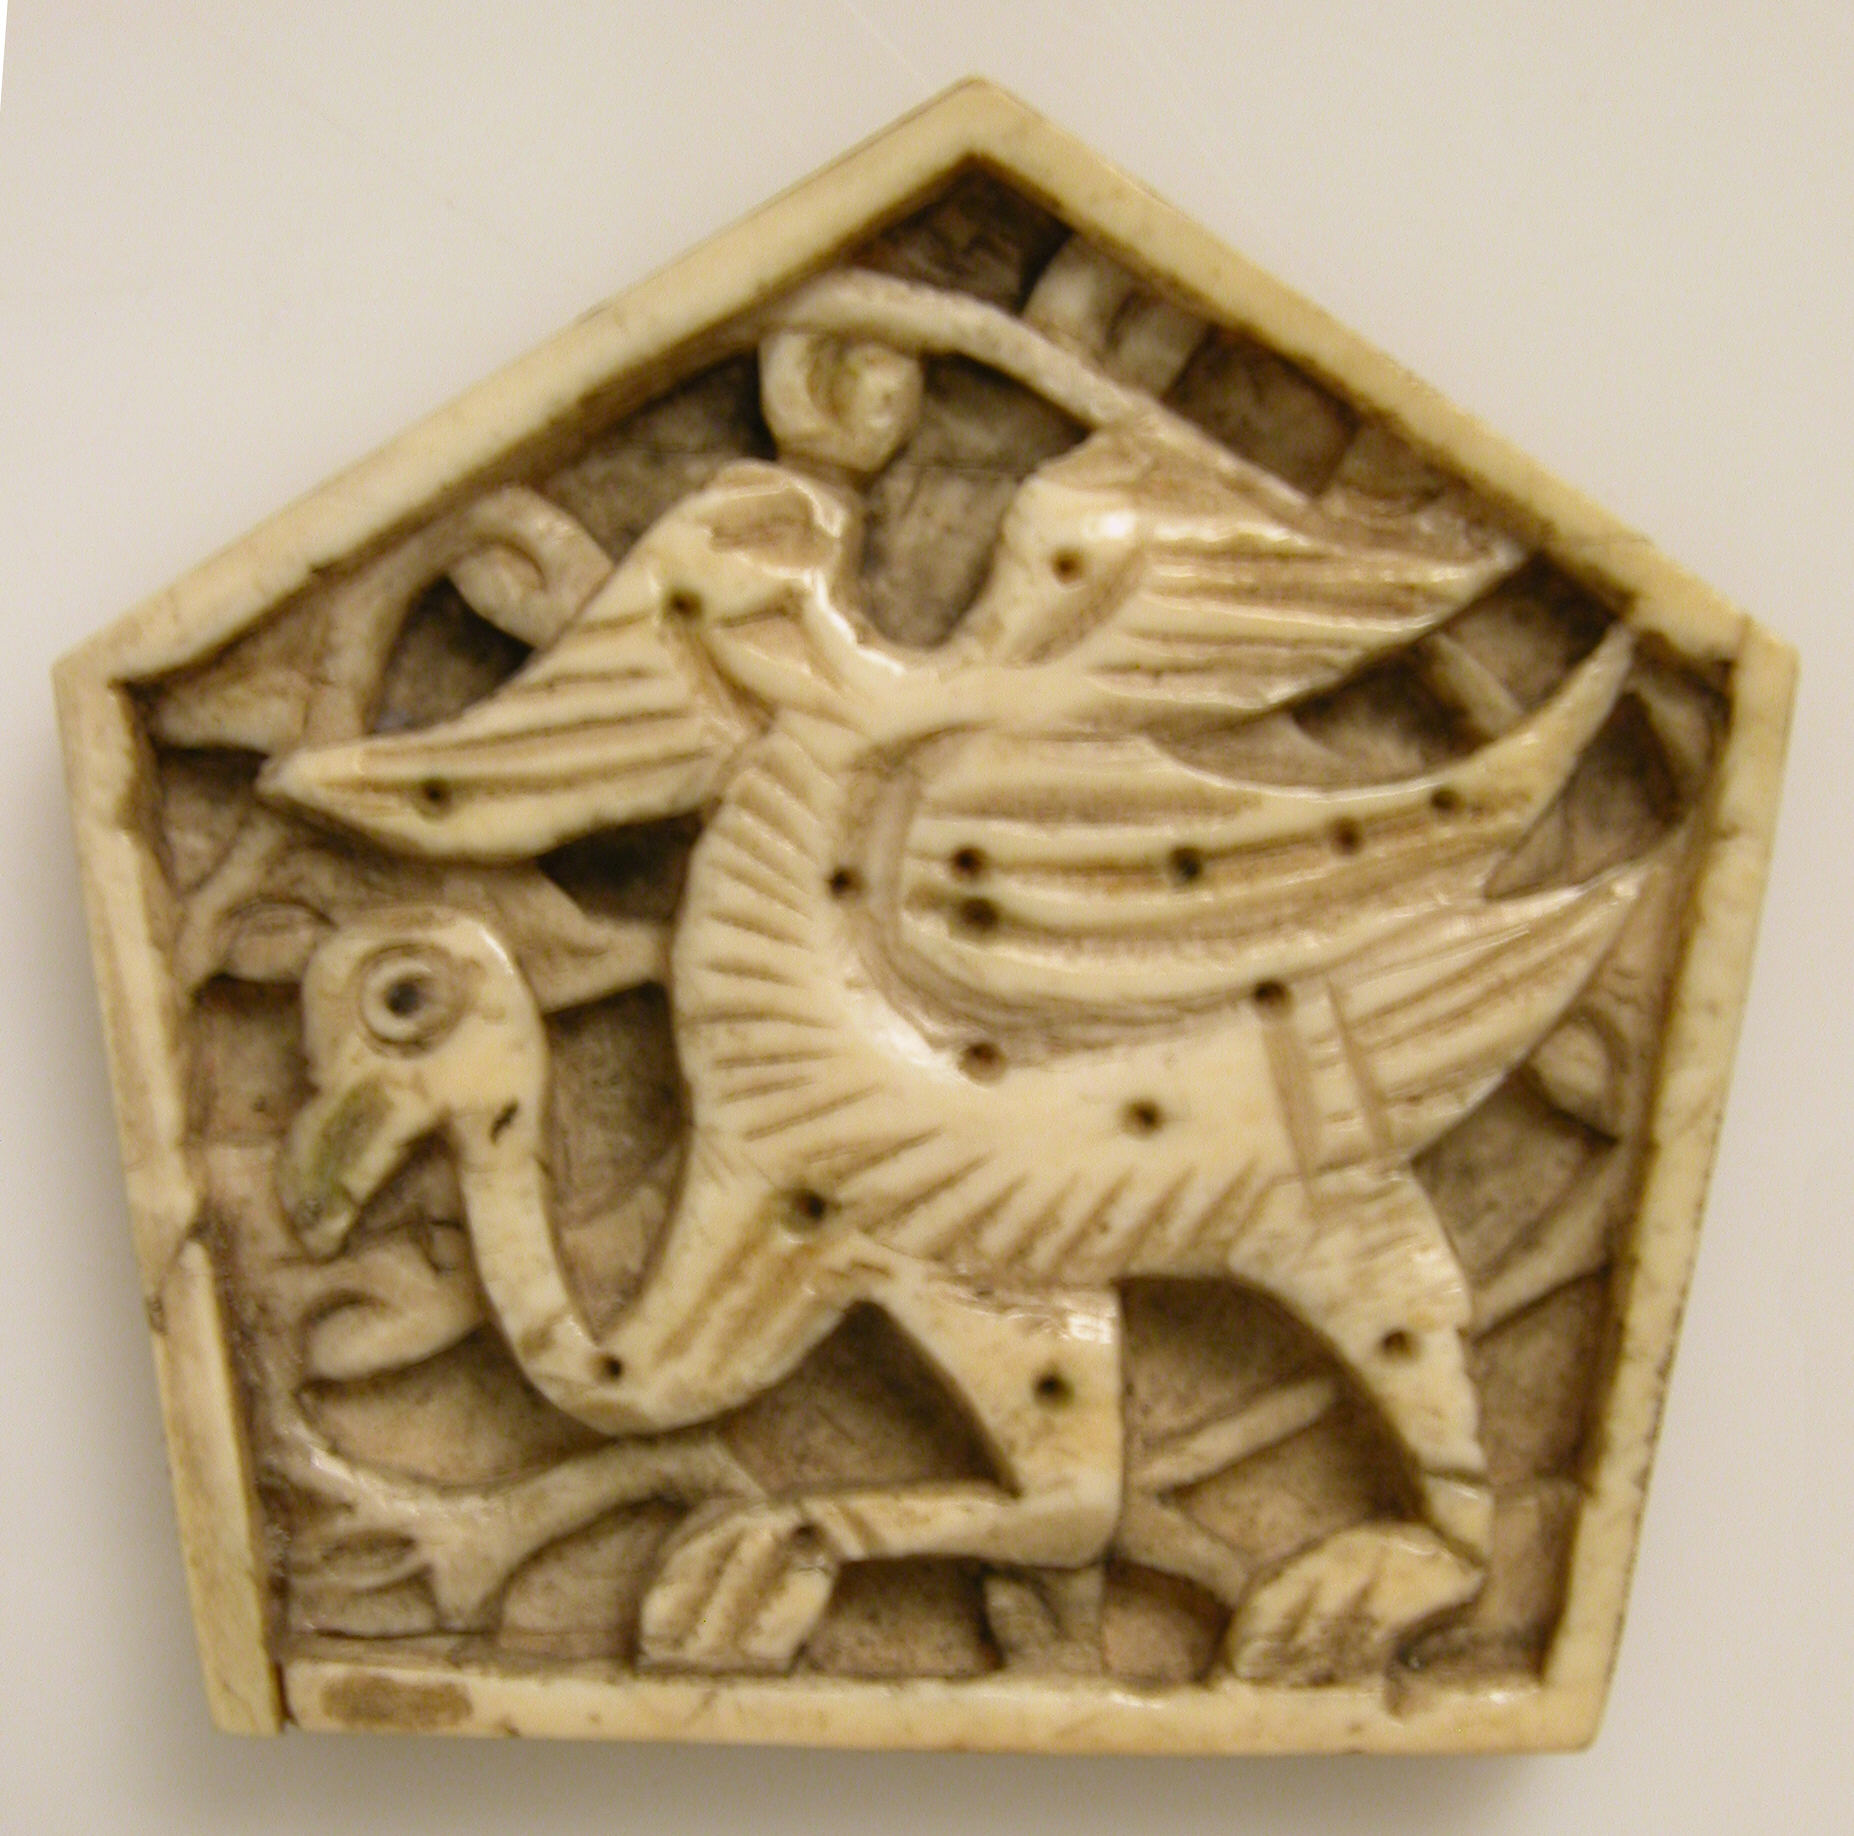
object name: plaque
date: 1101-1200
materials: bone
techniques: carving, incising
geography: italy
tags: mythical creatures